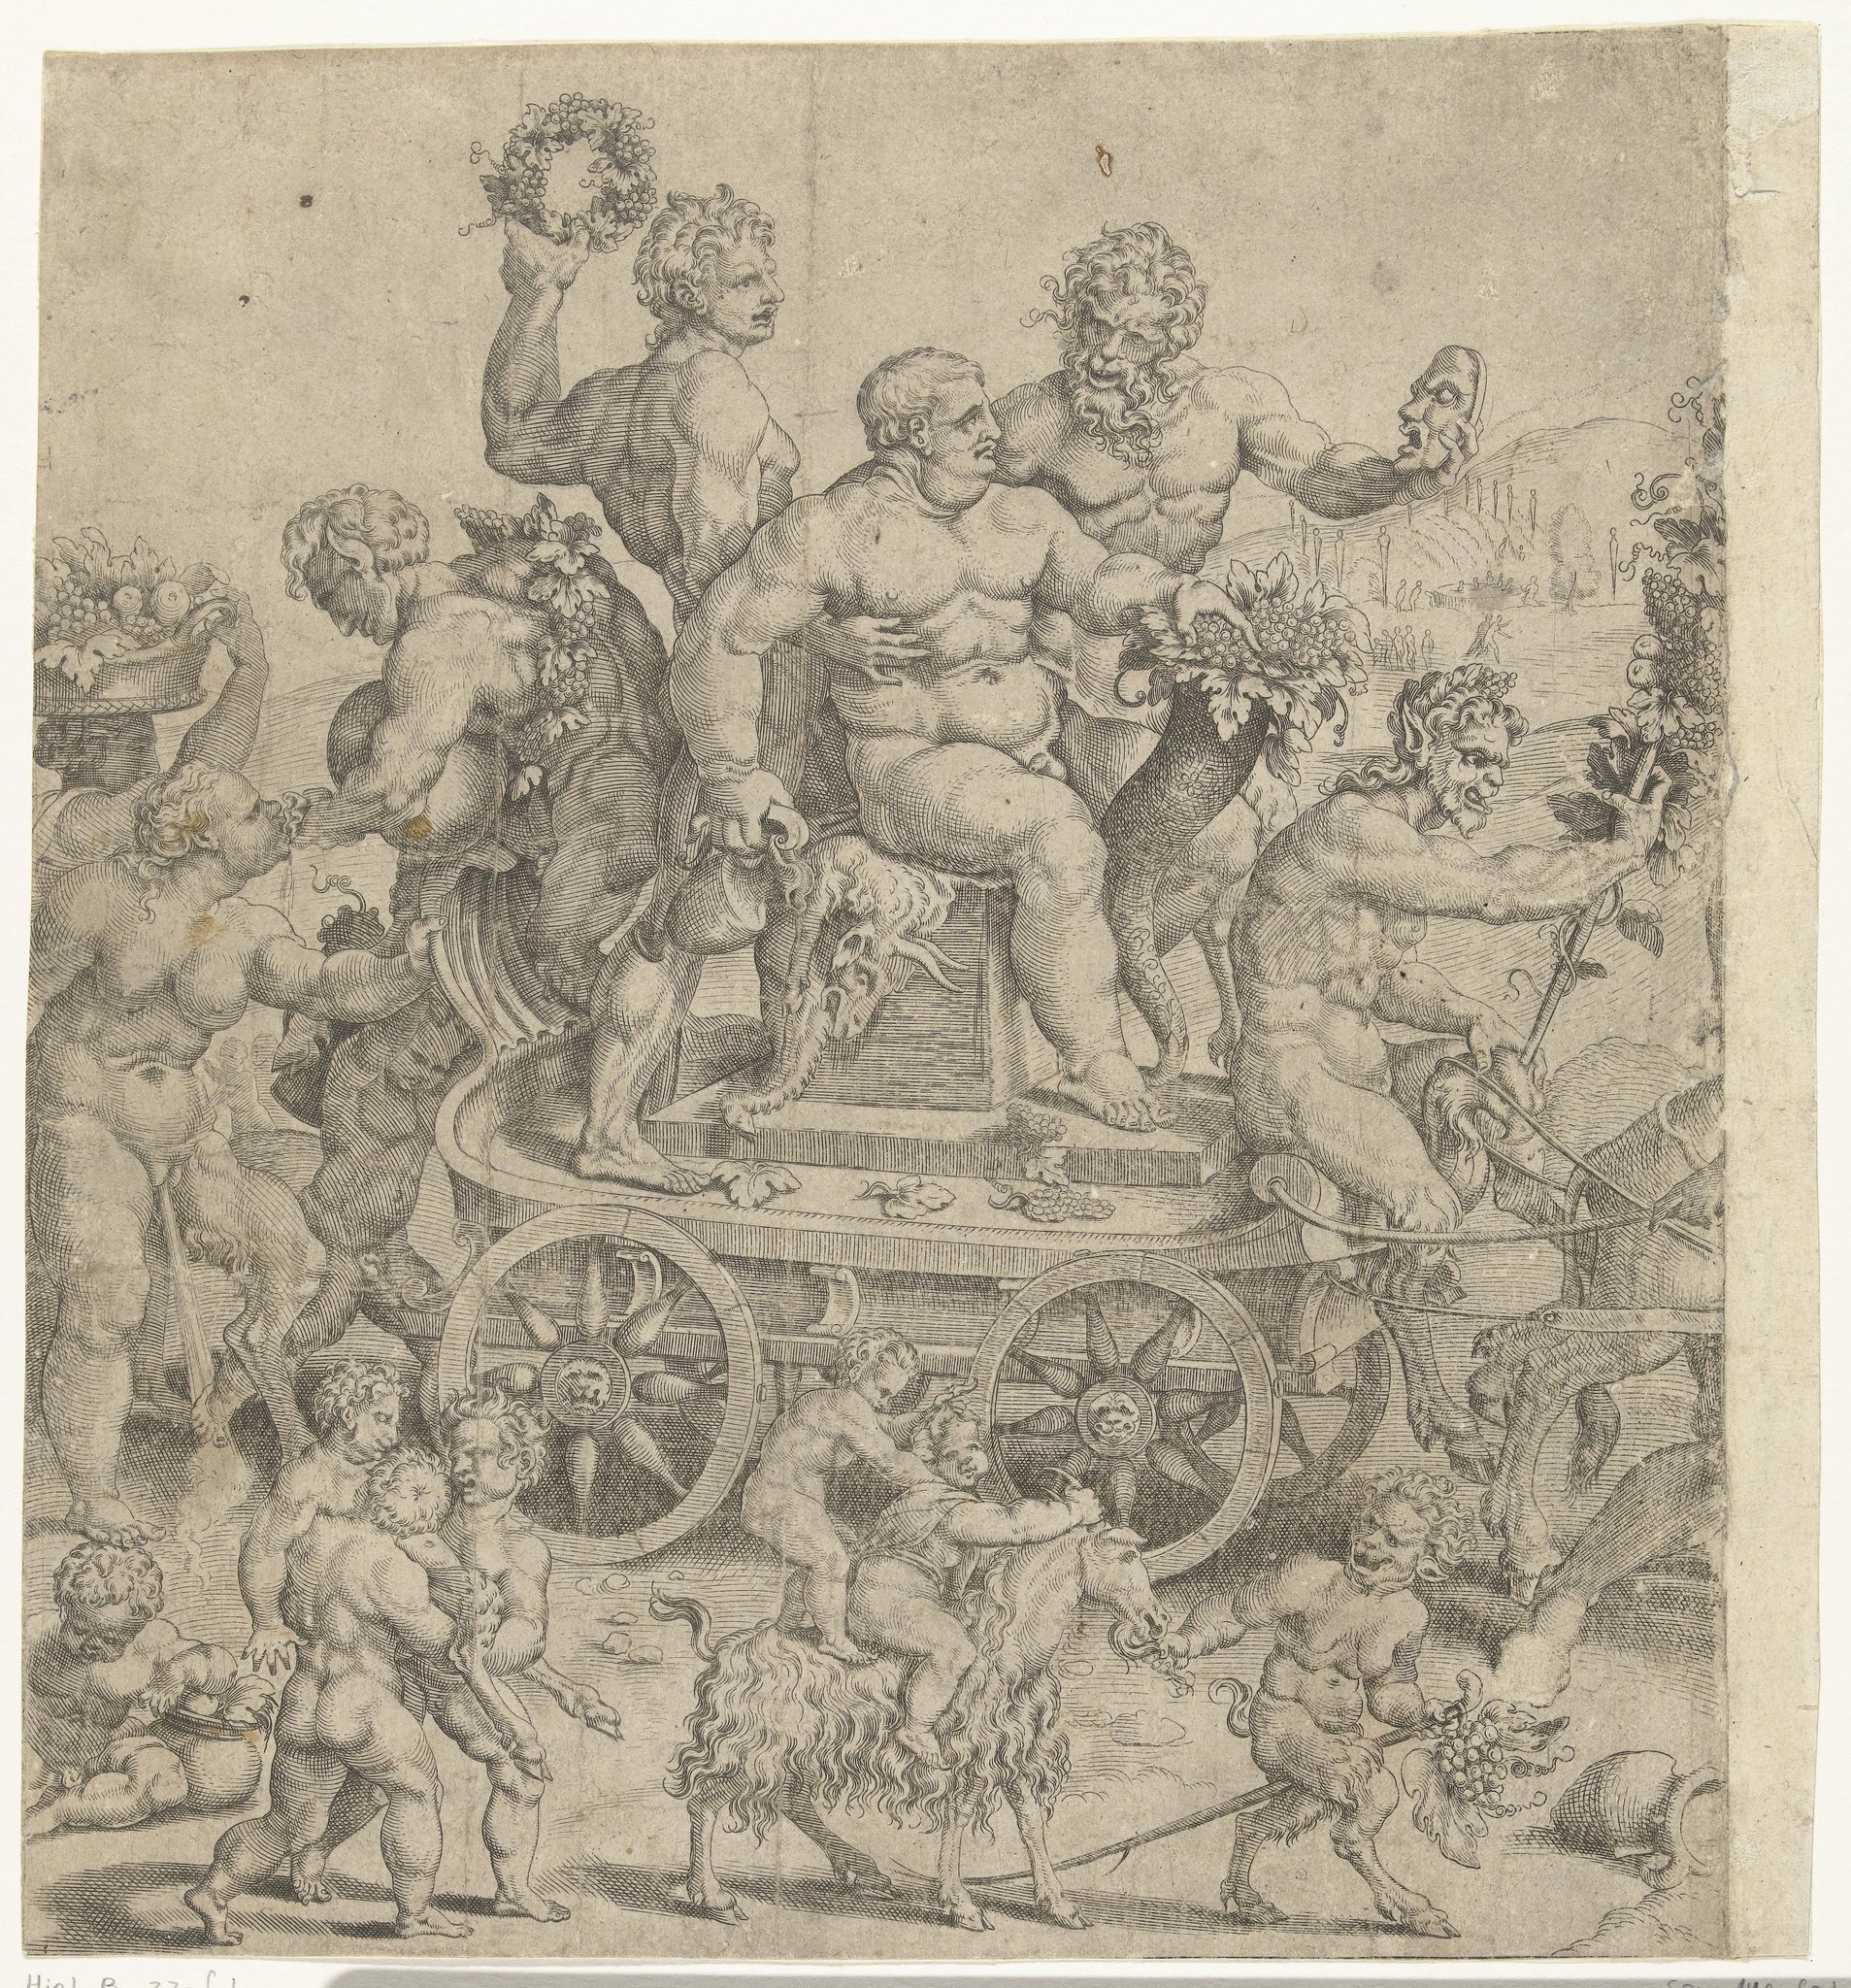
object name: print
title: Triomf van Bacchus, linker plaat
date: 1543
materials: paper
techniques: engraving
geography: antwerp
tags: triumph of bacchus; 'carro di bacco' (ripa)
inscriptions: collector's mark: ‘Hinloopen’, collector's mark: Lugt 11, collector's mark: Lugt 10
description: Optocht ter ere van de God Bacchus. Op een triomfwagen zit Bacchus met een hoorn gevuld met druiventrossen naast zich en een kruik met wijn in zijn hand.In de stoet lopen saters en putti uitgelaten te feesten. Linker deel van een prent bestaande uit drie platen.